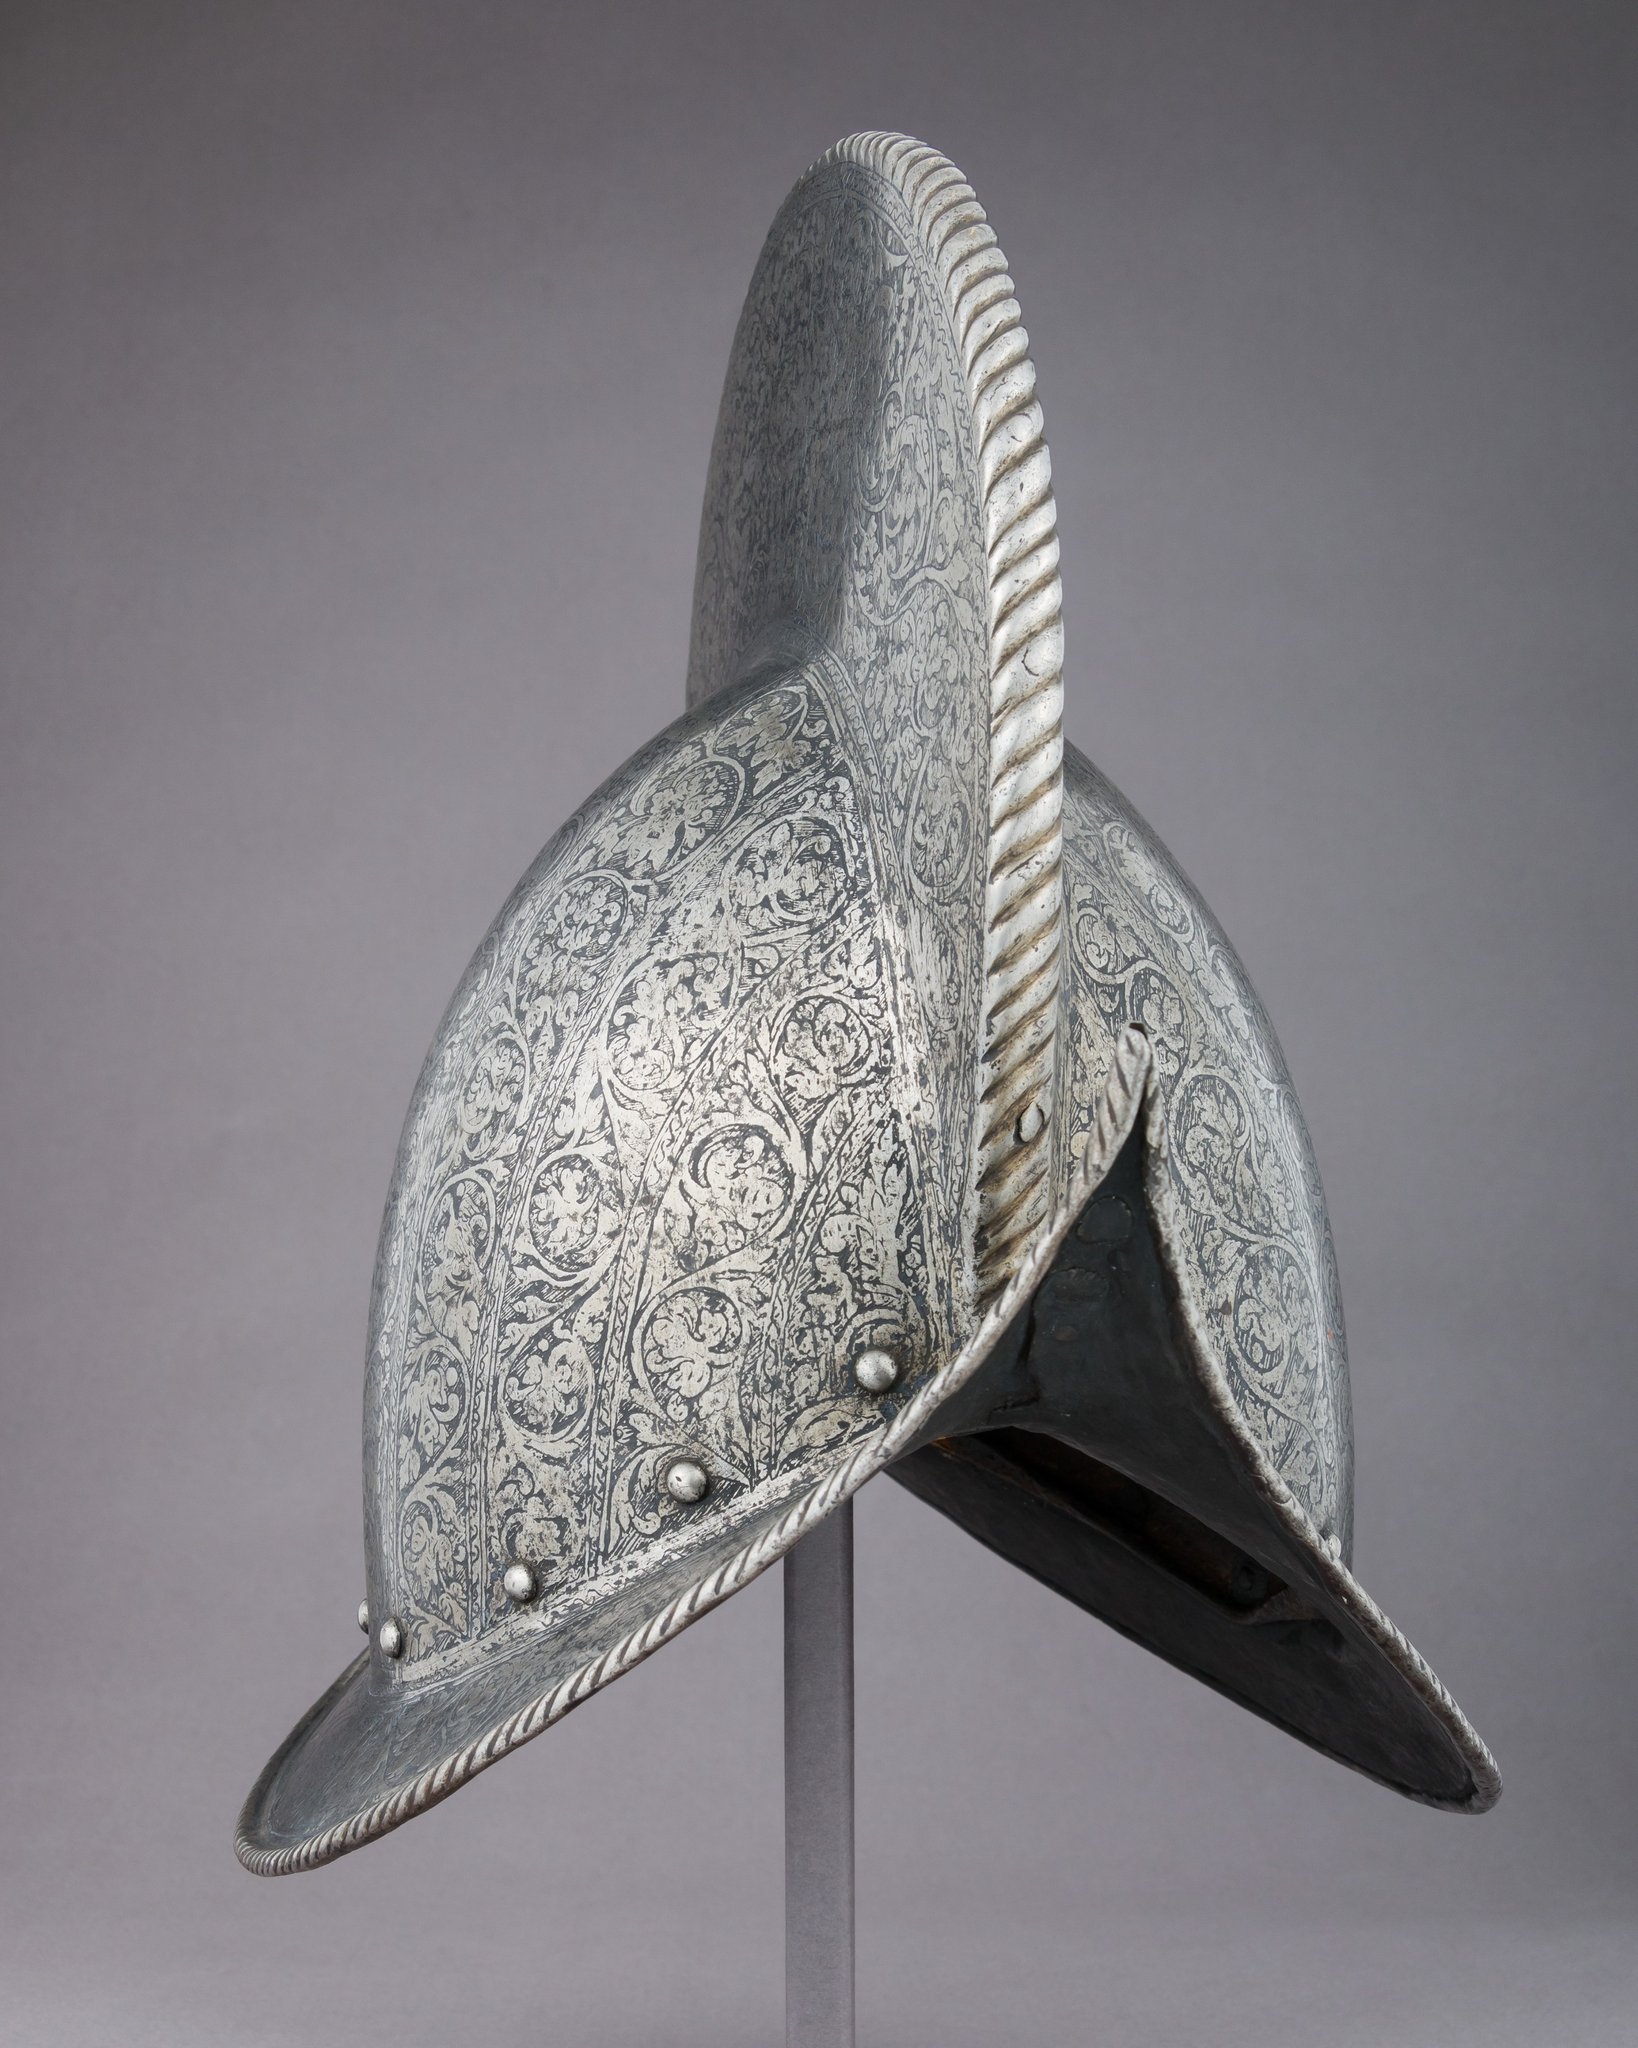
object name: morion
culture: french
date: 1575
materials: leather, steel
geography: france